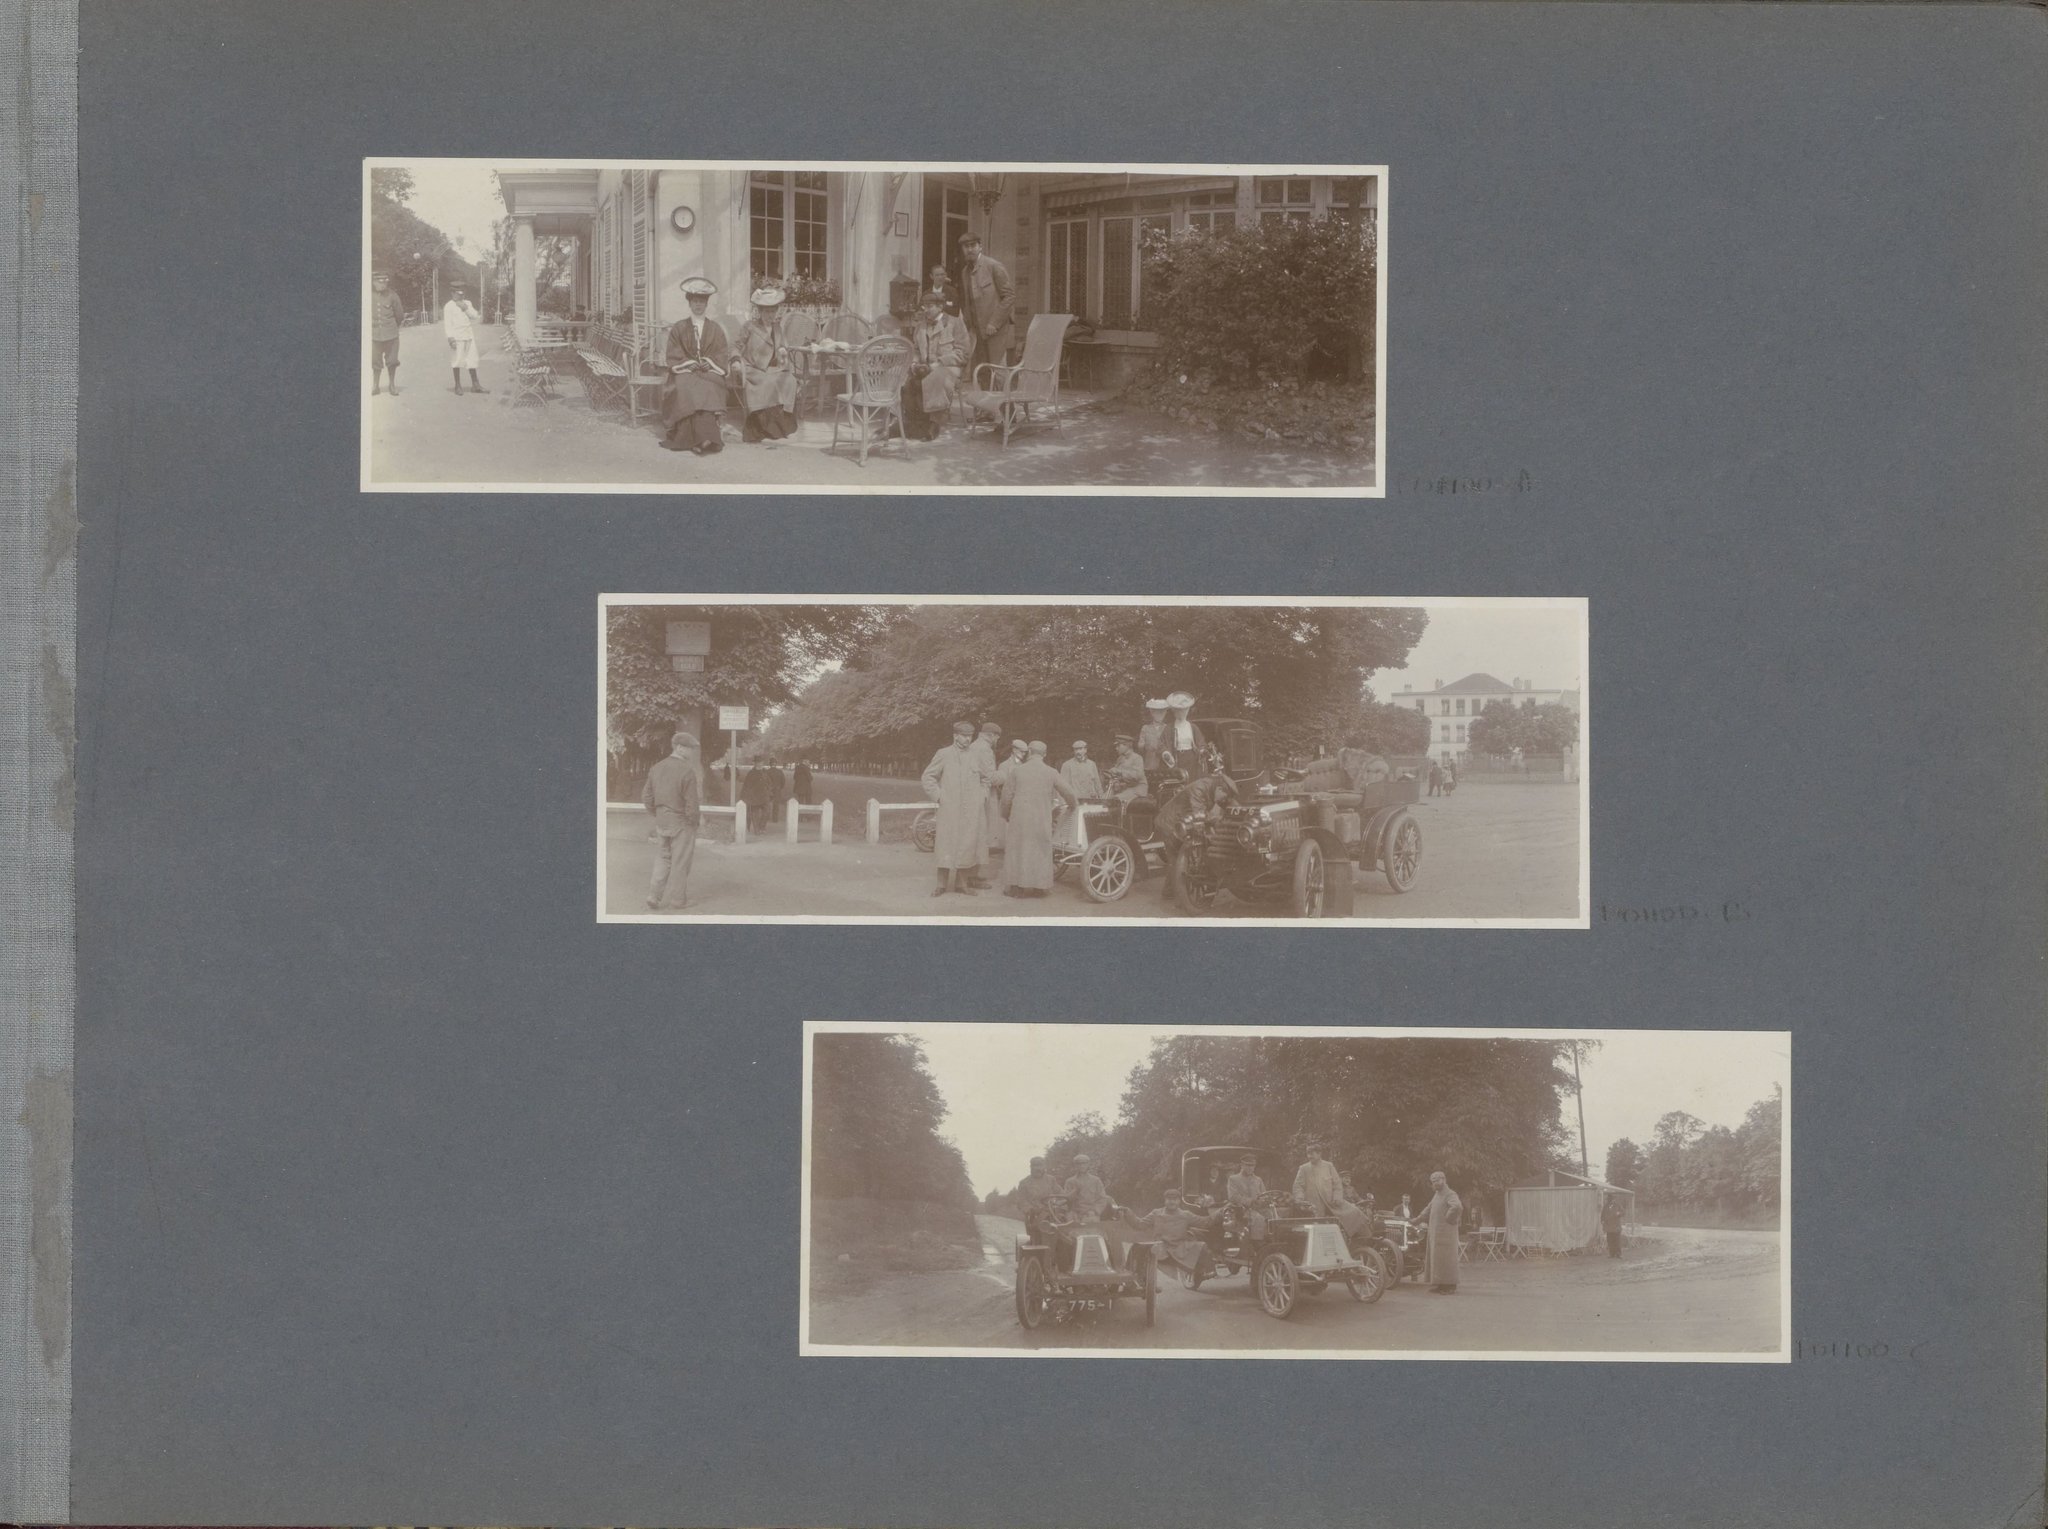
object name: photograph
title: Mannen en vrouwen bij auto's in Frankrijk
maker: Anonymous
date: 1902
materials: paper, photographic support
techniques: daylight paper print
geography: france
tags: automobile, france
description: Onderdeel van Fotoalbum van een legeroefening in Zuidwest-Frankrijk in 1902.